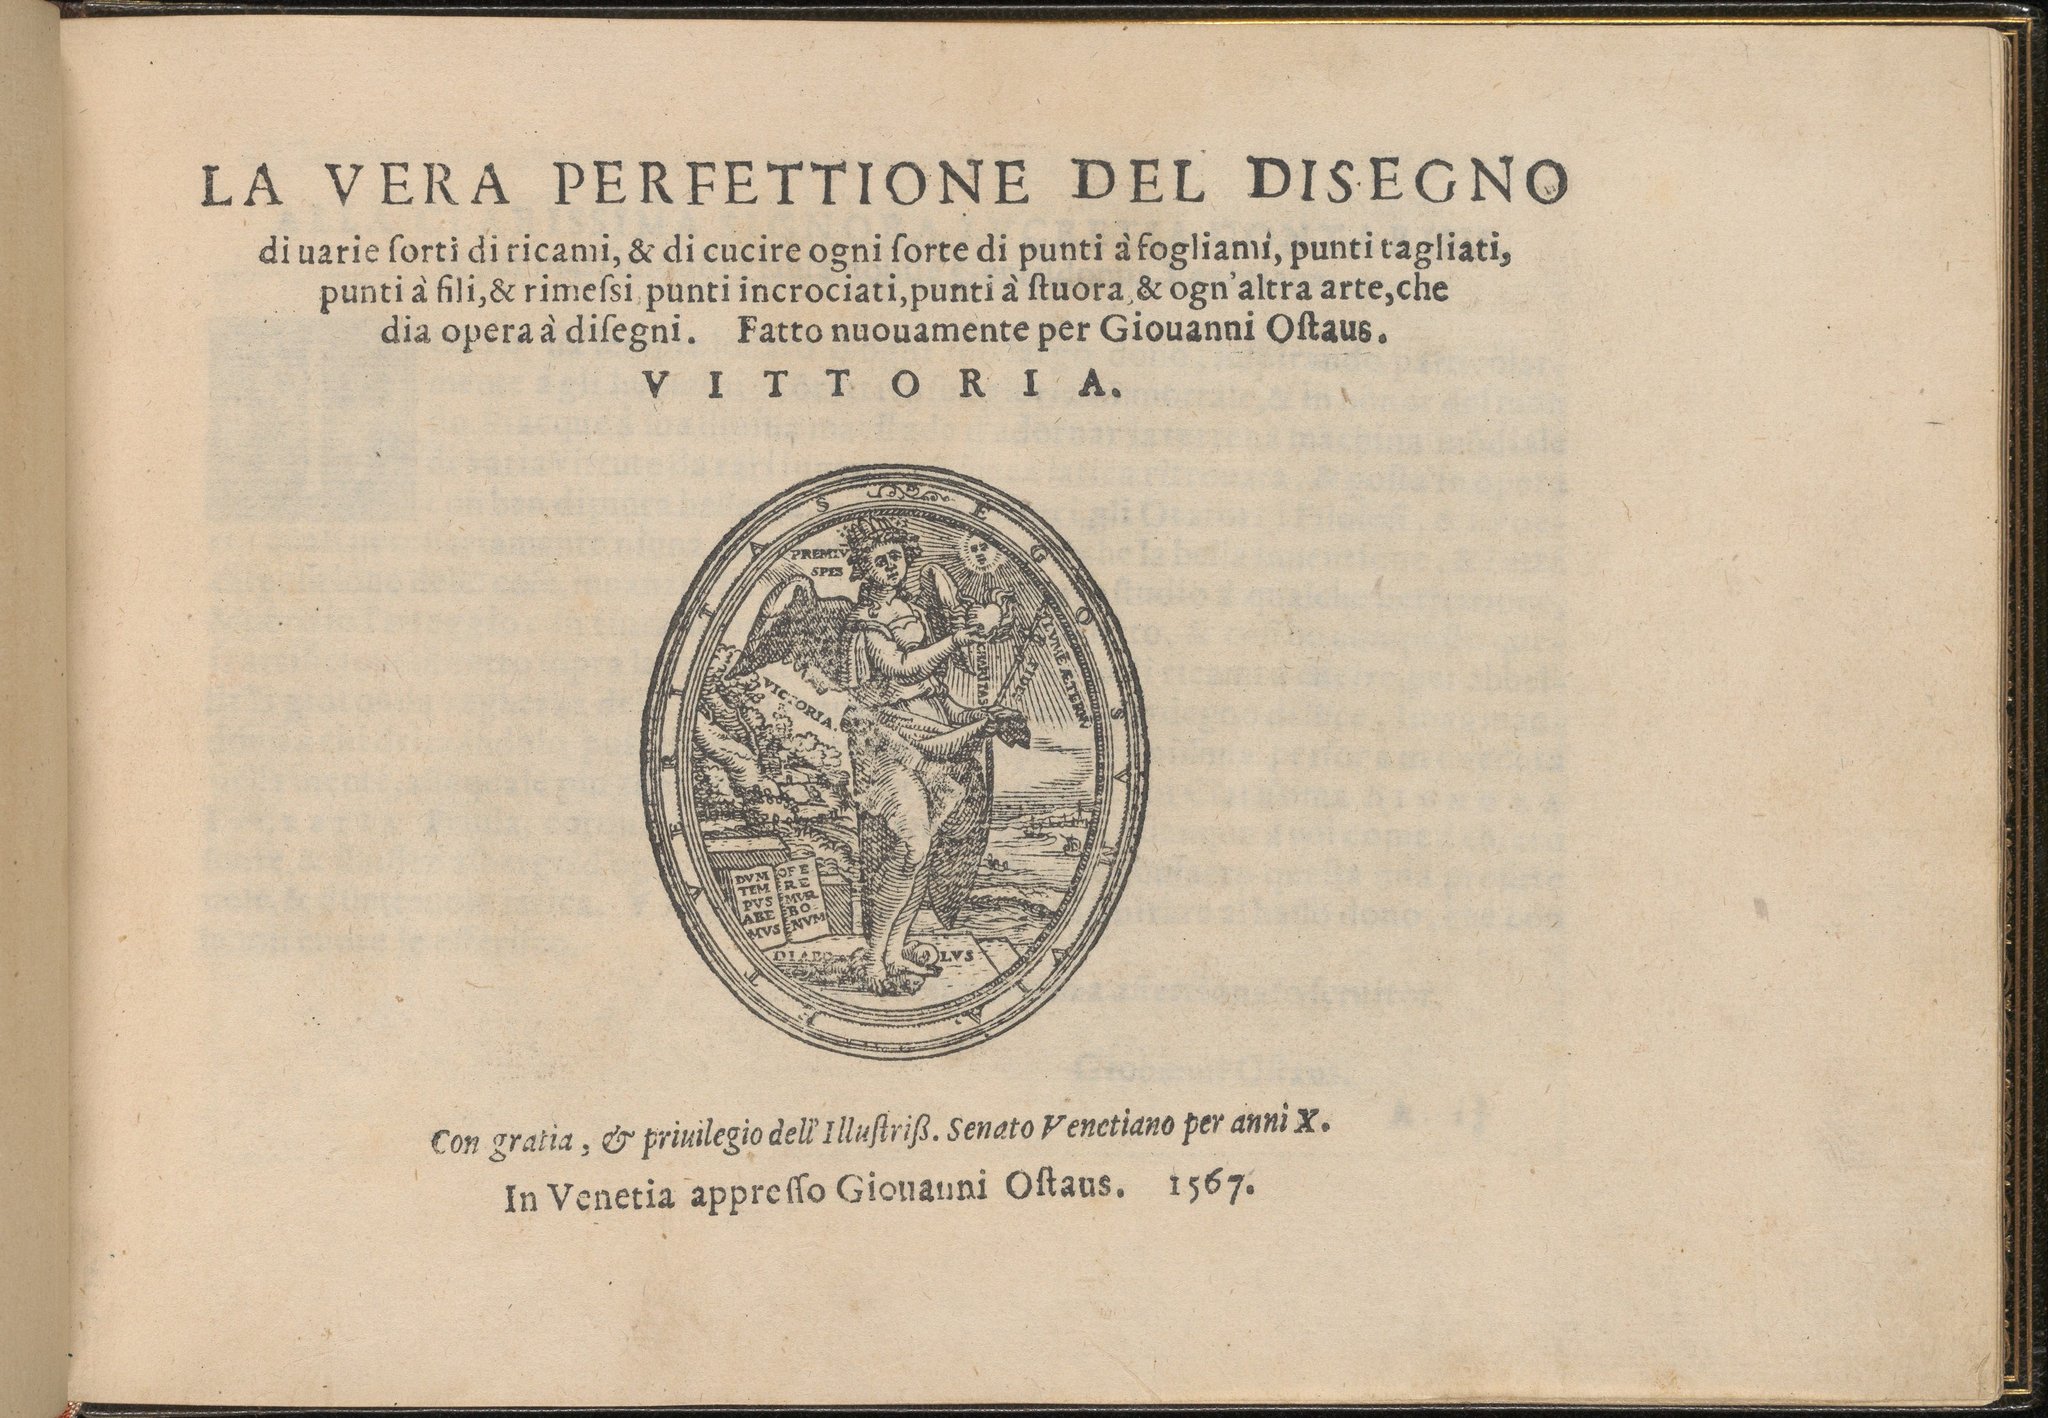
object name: book print ornament architecture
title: La Vera Perfettione del Disegno di varie sorti di recami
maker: giovanni ostaus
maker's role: publisher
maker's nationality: italian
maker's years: 1507-1607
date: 1567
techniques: woodcut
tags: men